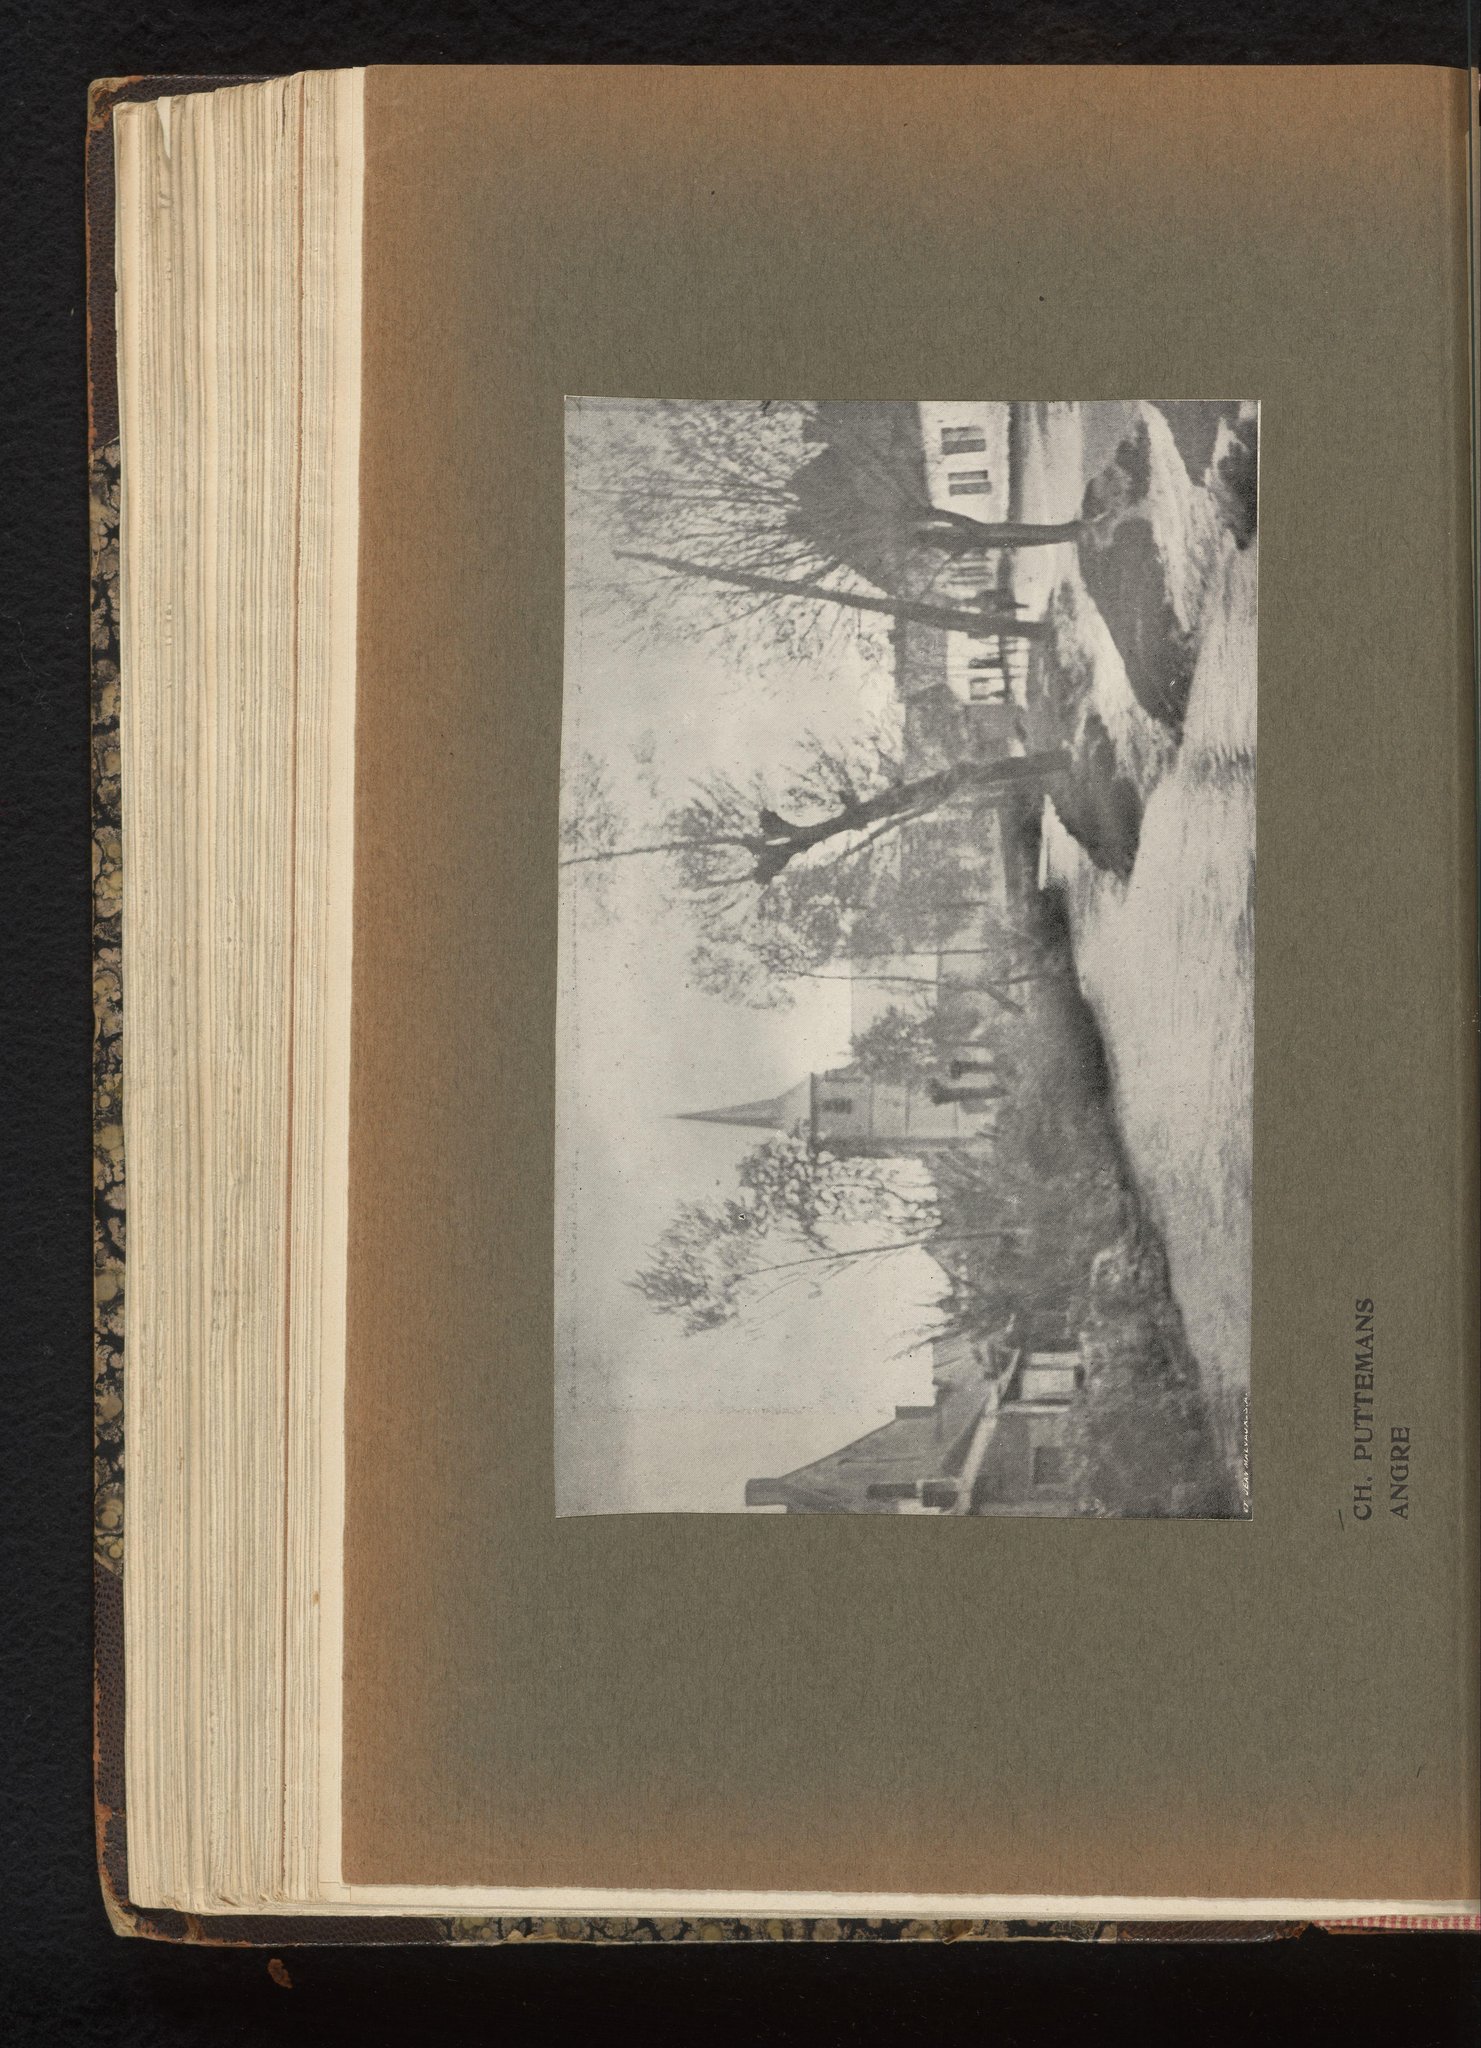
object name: page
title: Stadsgezicht op Angre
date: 1897-1902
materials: paper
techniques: autotype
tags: city-view in general; 'veduta'